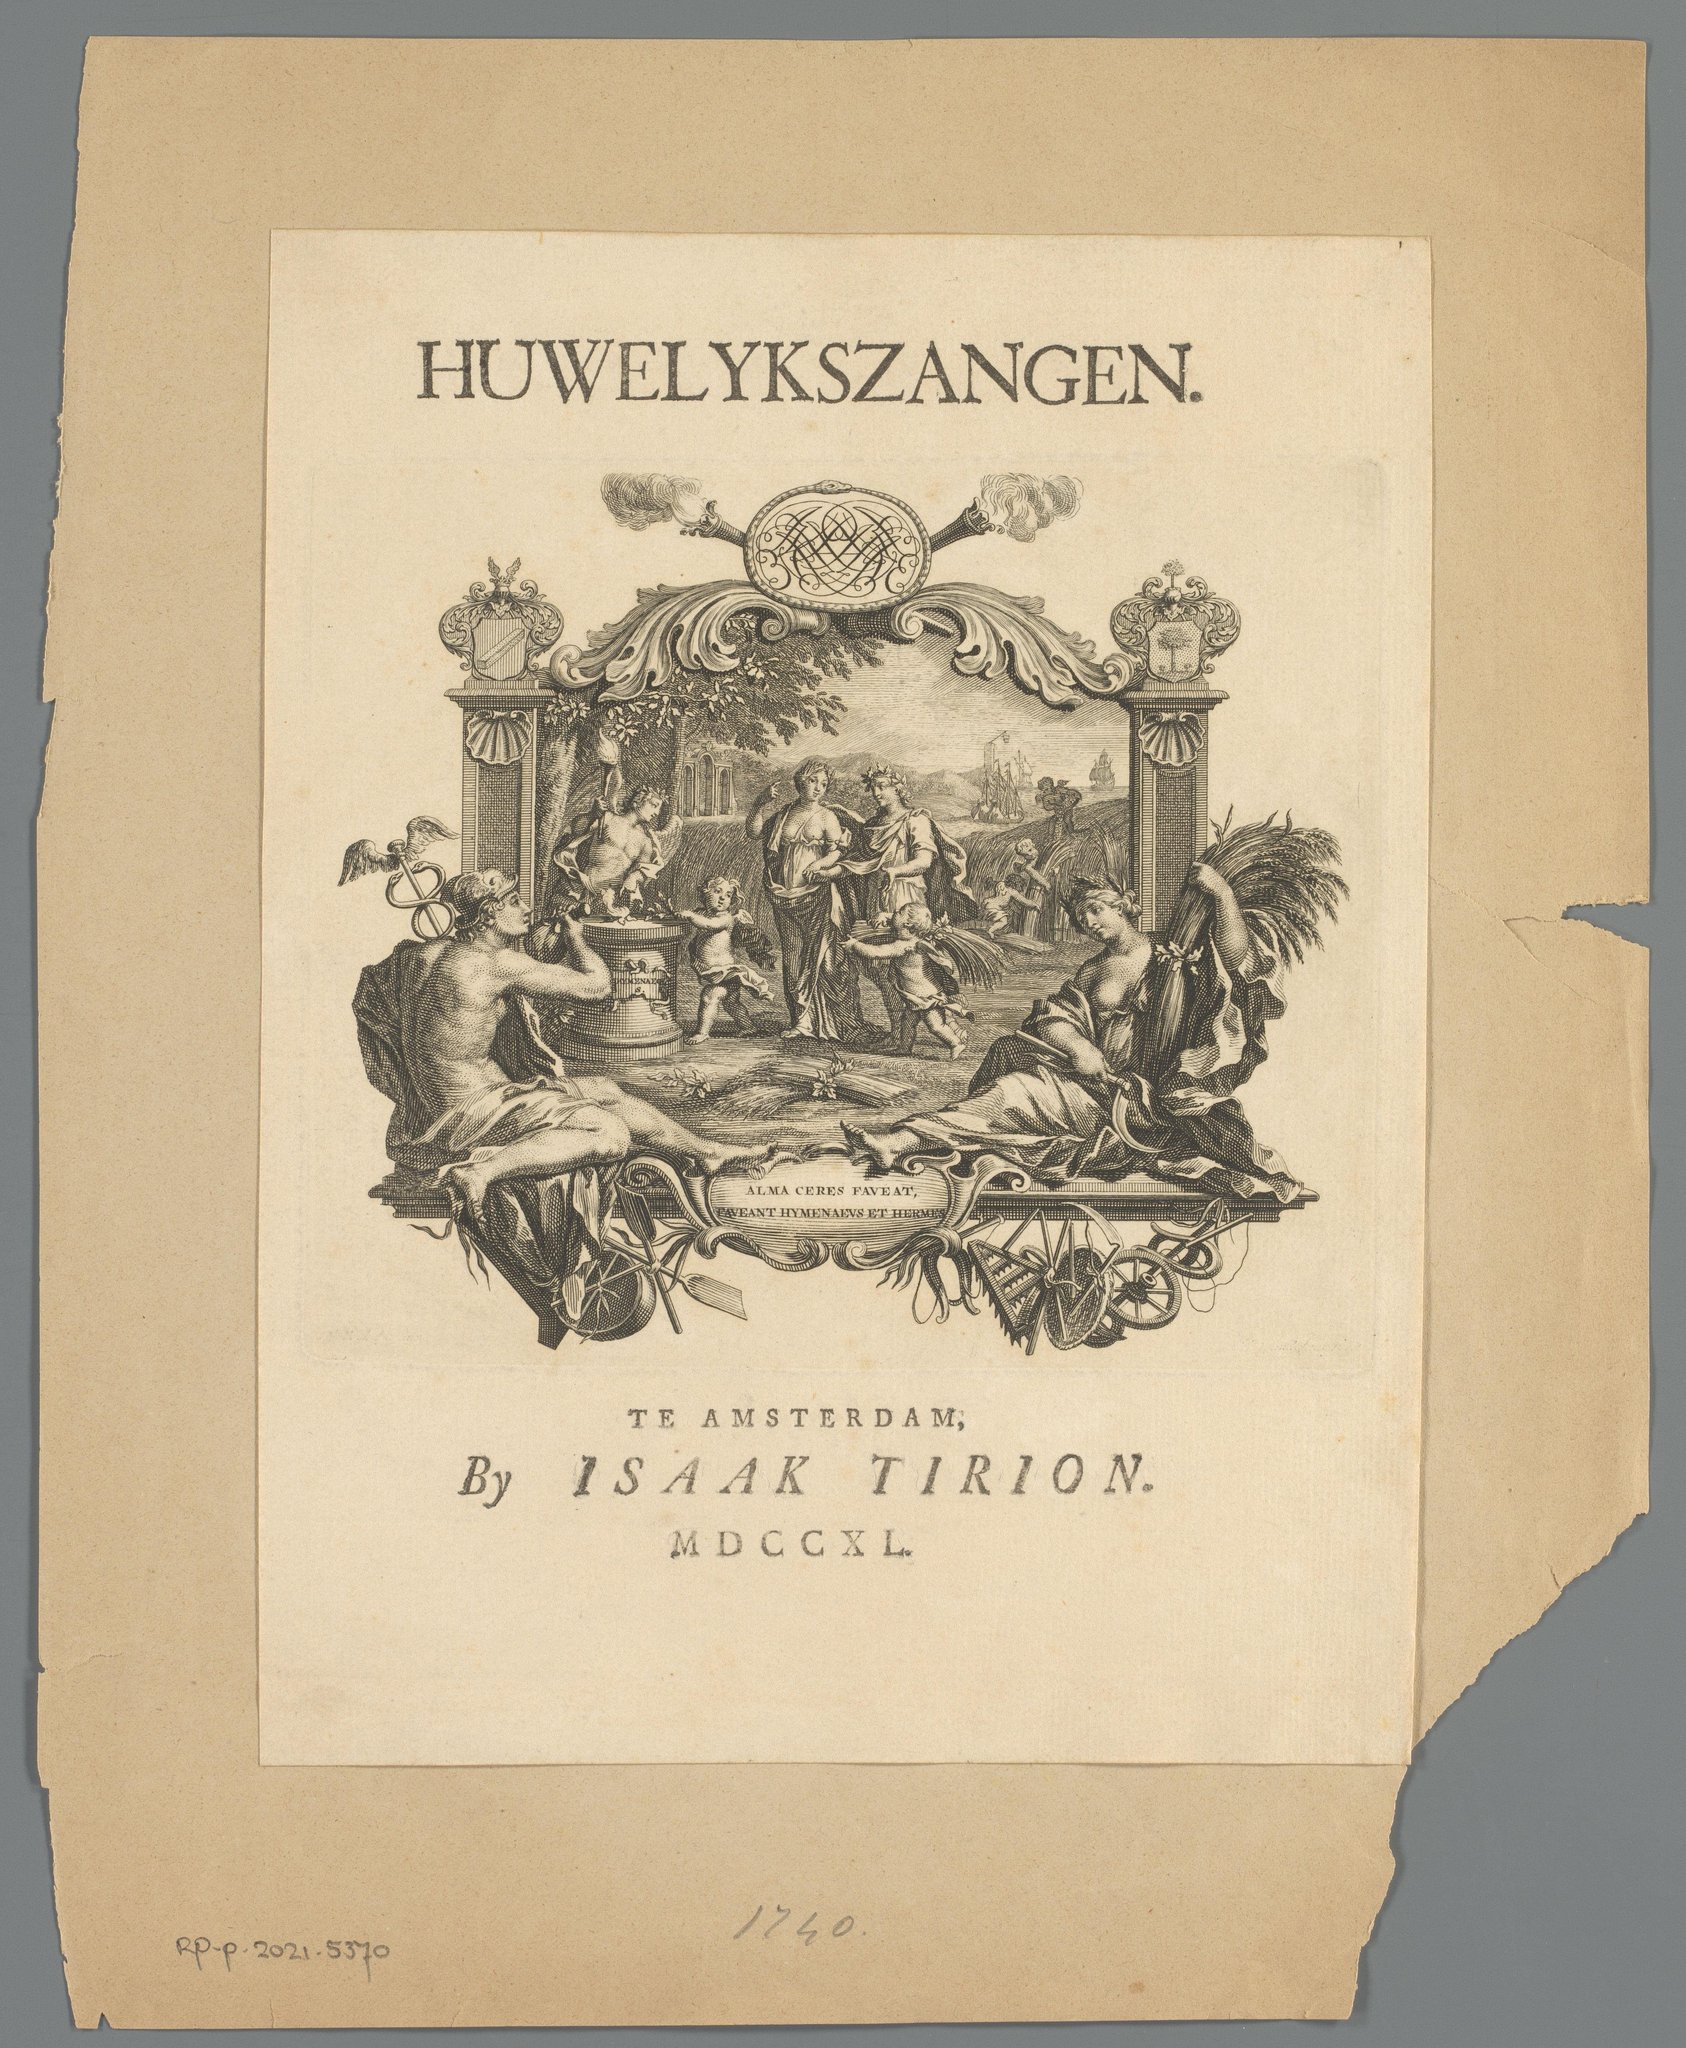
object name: titelblad, titelpagina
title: Titelpagina voor: Huwelykzangen, 1740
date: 1740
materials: paper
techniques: engraving, etching, letterpress printing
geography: amsterdam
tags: (story of) ceres (demeter), (story of) mercury (hermes), (civil) marriage ceremonies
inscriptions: date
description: Allegorie op het huwelijk. Mercurius en Ceres op de voorgrond, daarachter een engel met een toorts bij een offeraltaar waarnaar een man en vrouw hand in hand komen lopen. Met eronder het devies: 'Alma Ceres faveat, faveant Hymenaeus et Hermes'.